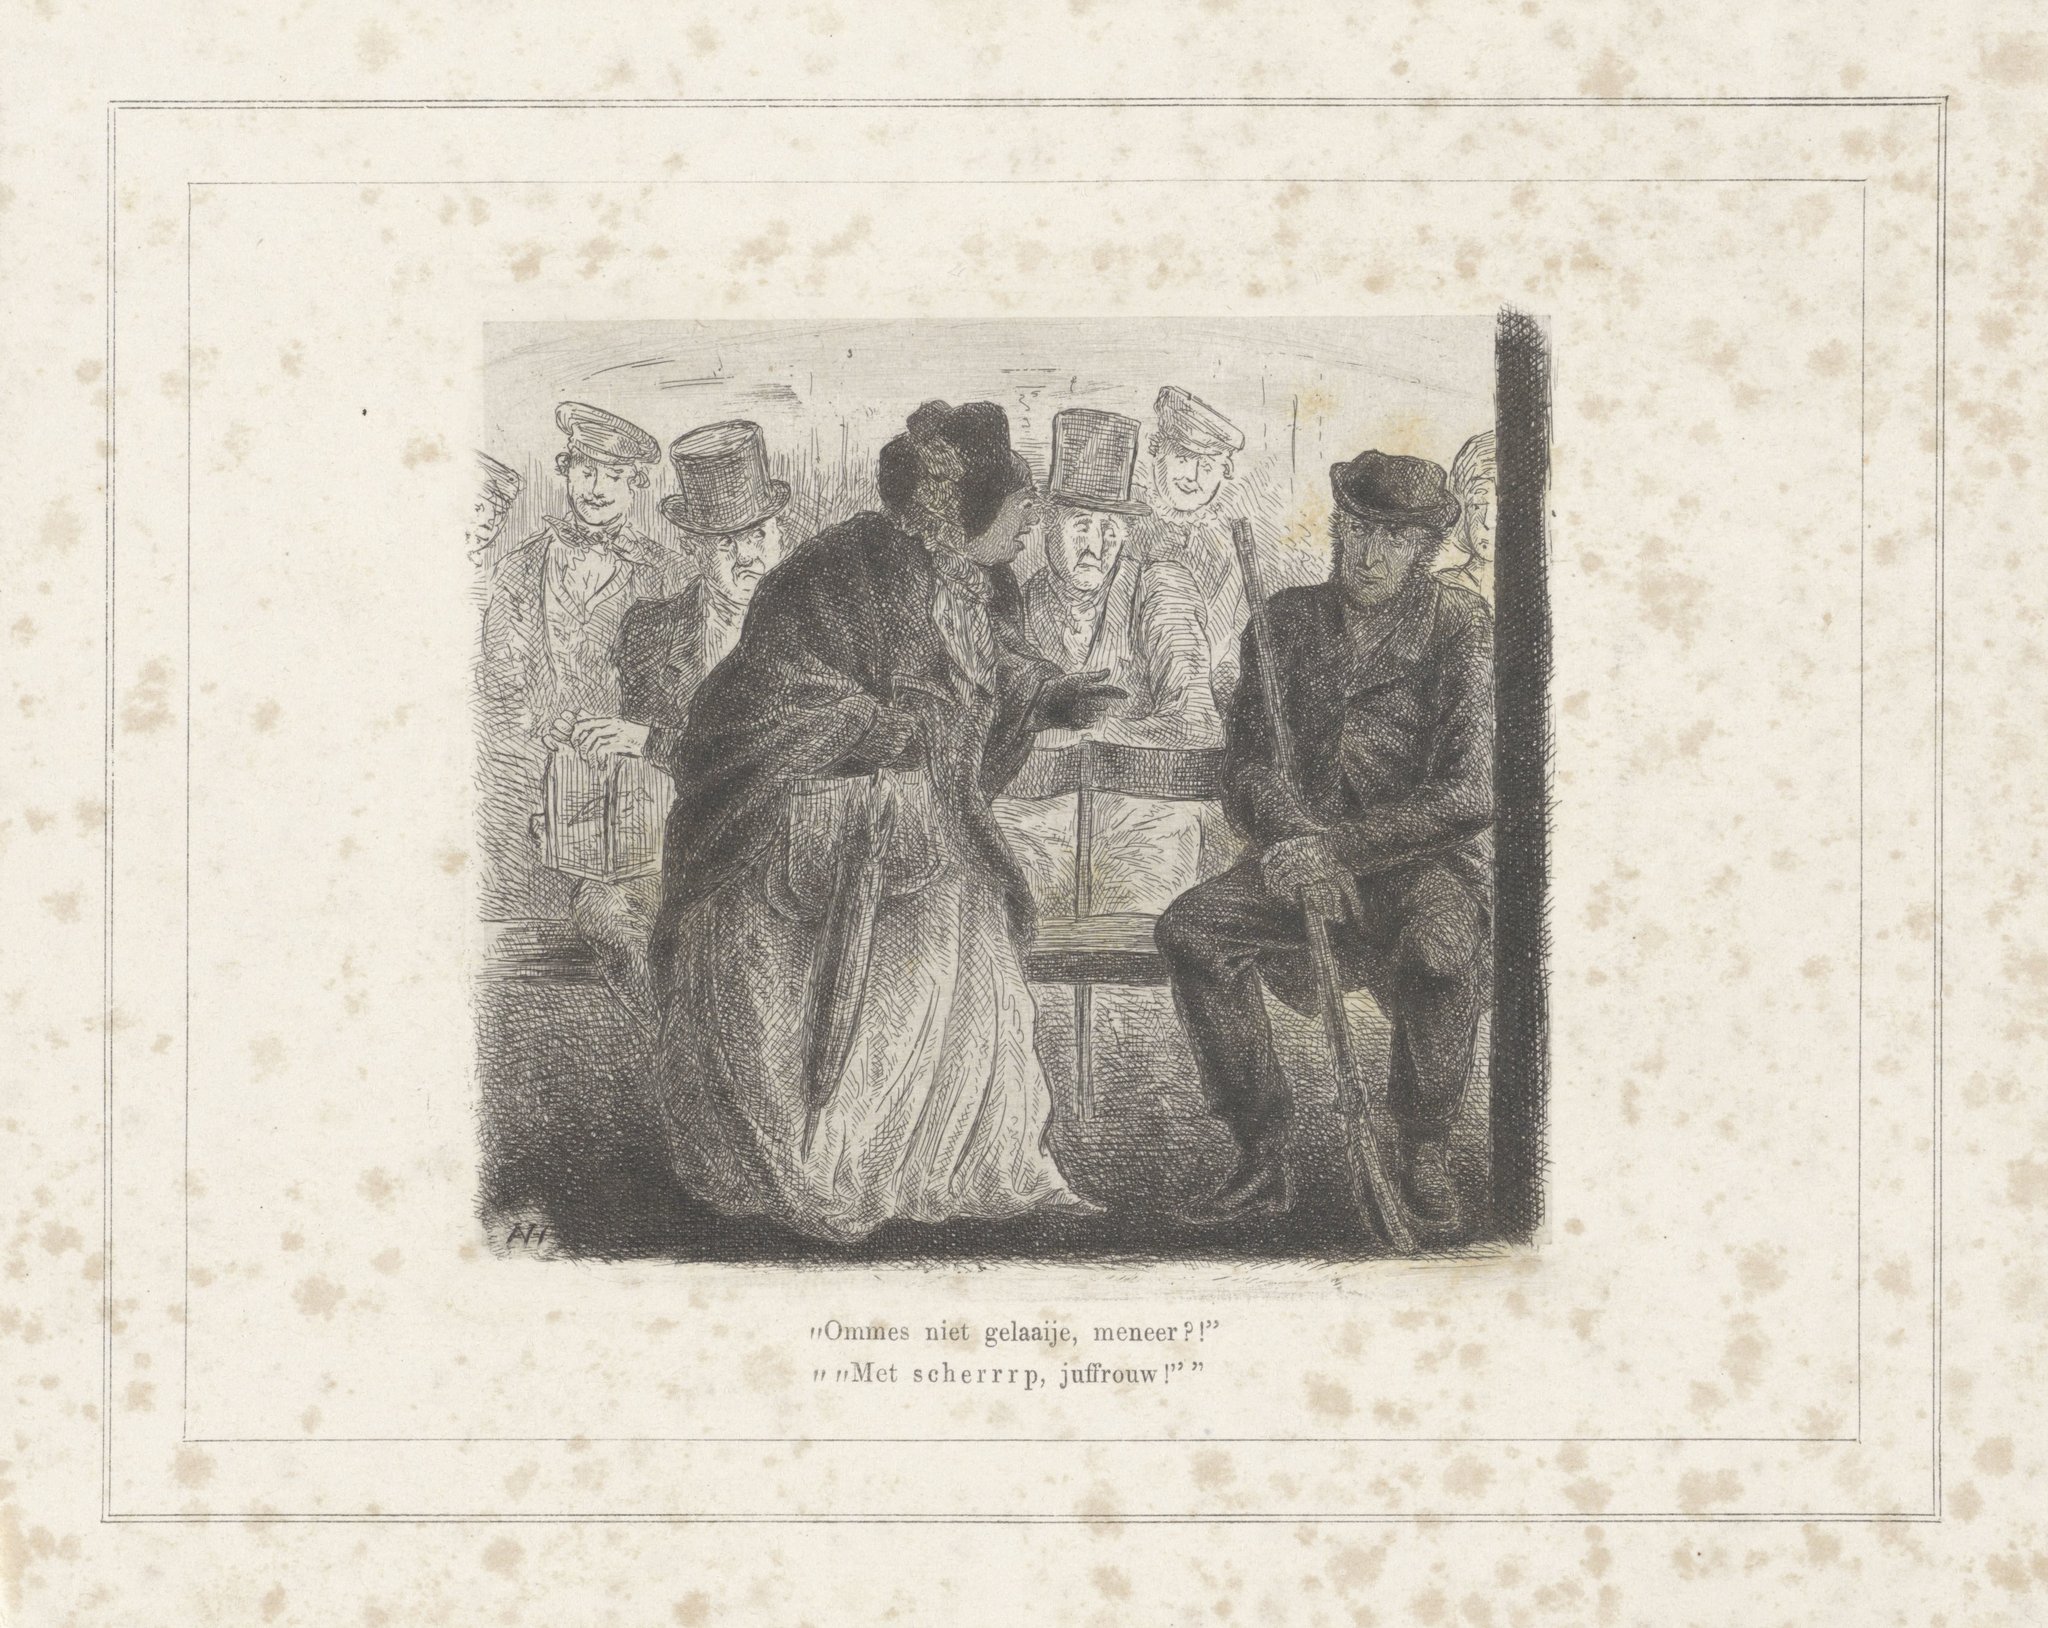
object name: print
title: "Ommes niet gelaaije, meneer?! Met scherrrp, juffrouw"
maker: alexander ver huell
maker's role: draughtsman, print maker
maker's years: 1822-1897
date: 1832-1879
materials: paper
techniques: engraving, etching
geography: netherlands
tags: umbrella, firearms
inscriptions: collector's mark: Lugt 2228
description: Een staande vrouw met een paraplu in haar hand spreekt een man aan die naast haar op een bank zit met een geweer in zijn hand. Op de achtergrond kijken mannen toe.